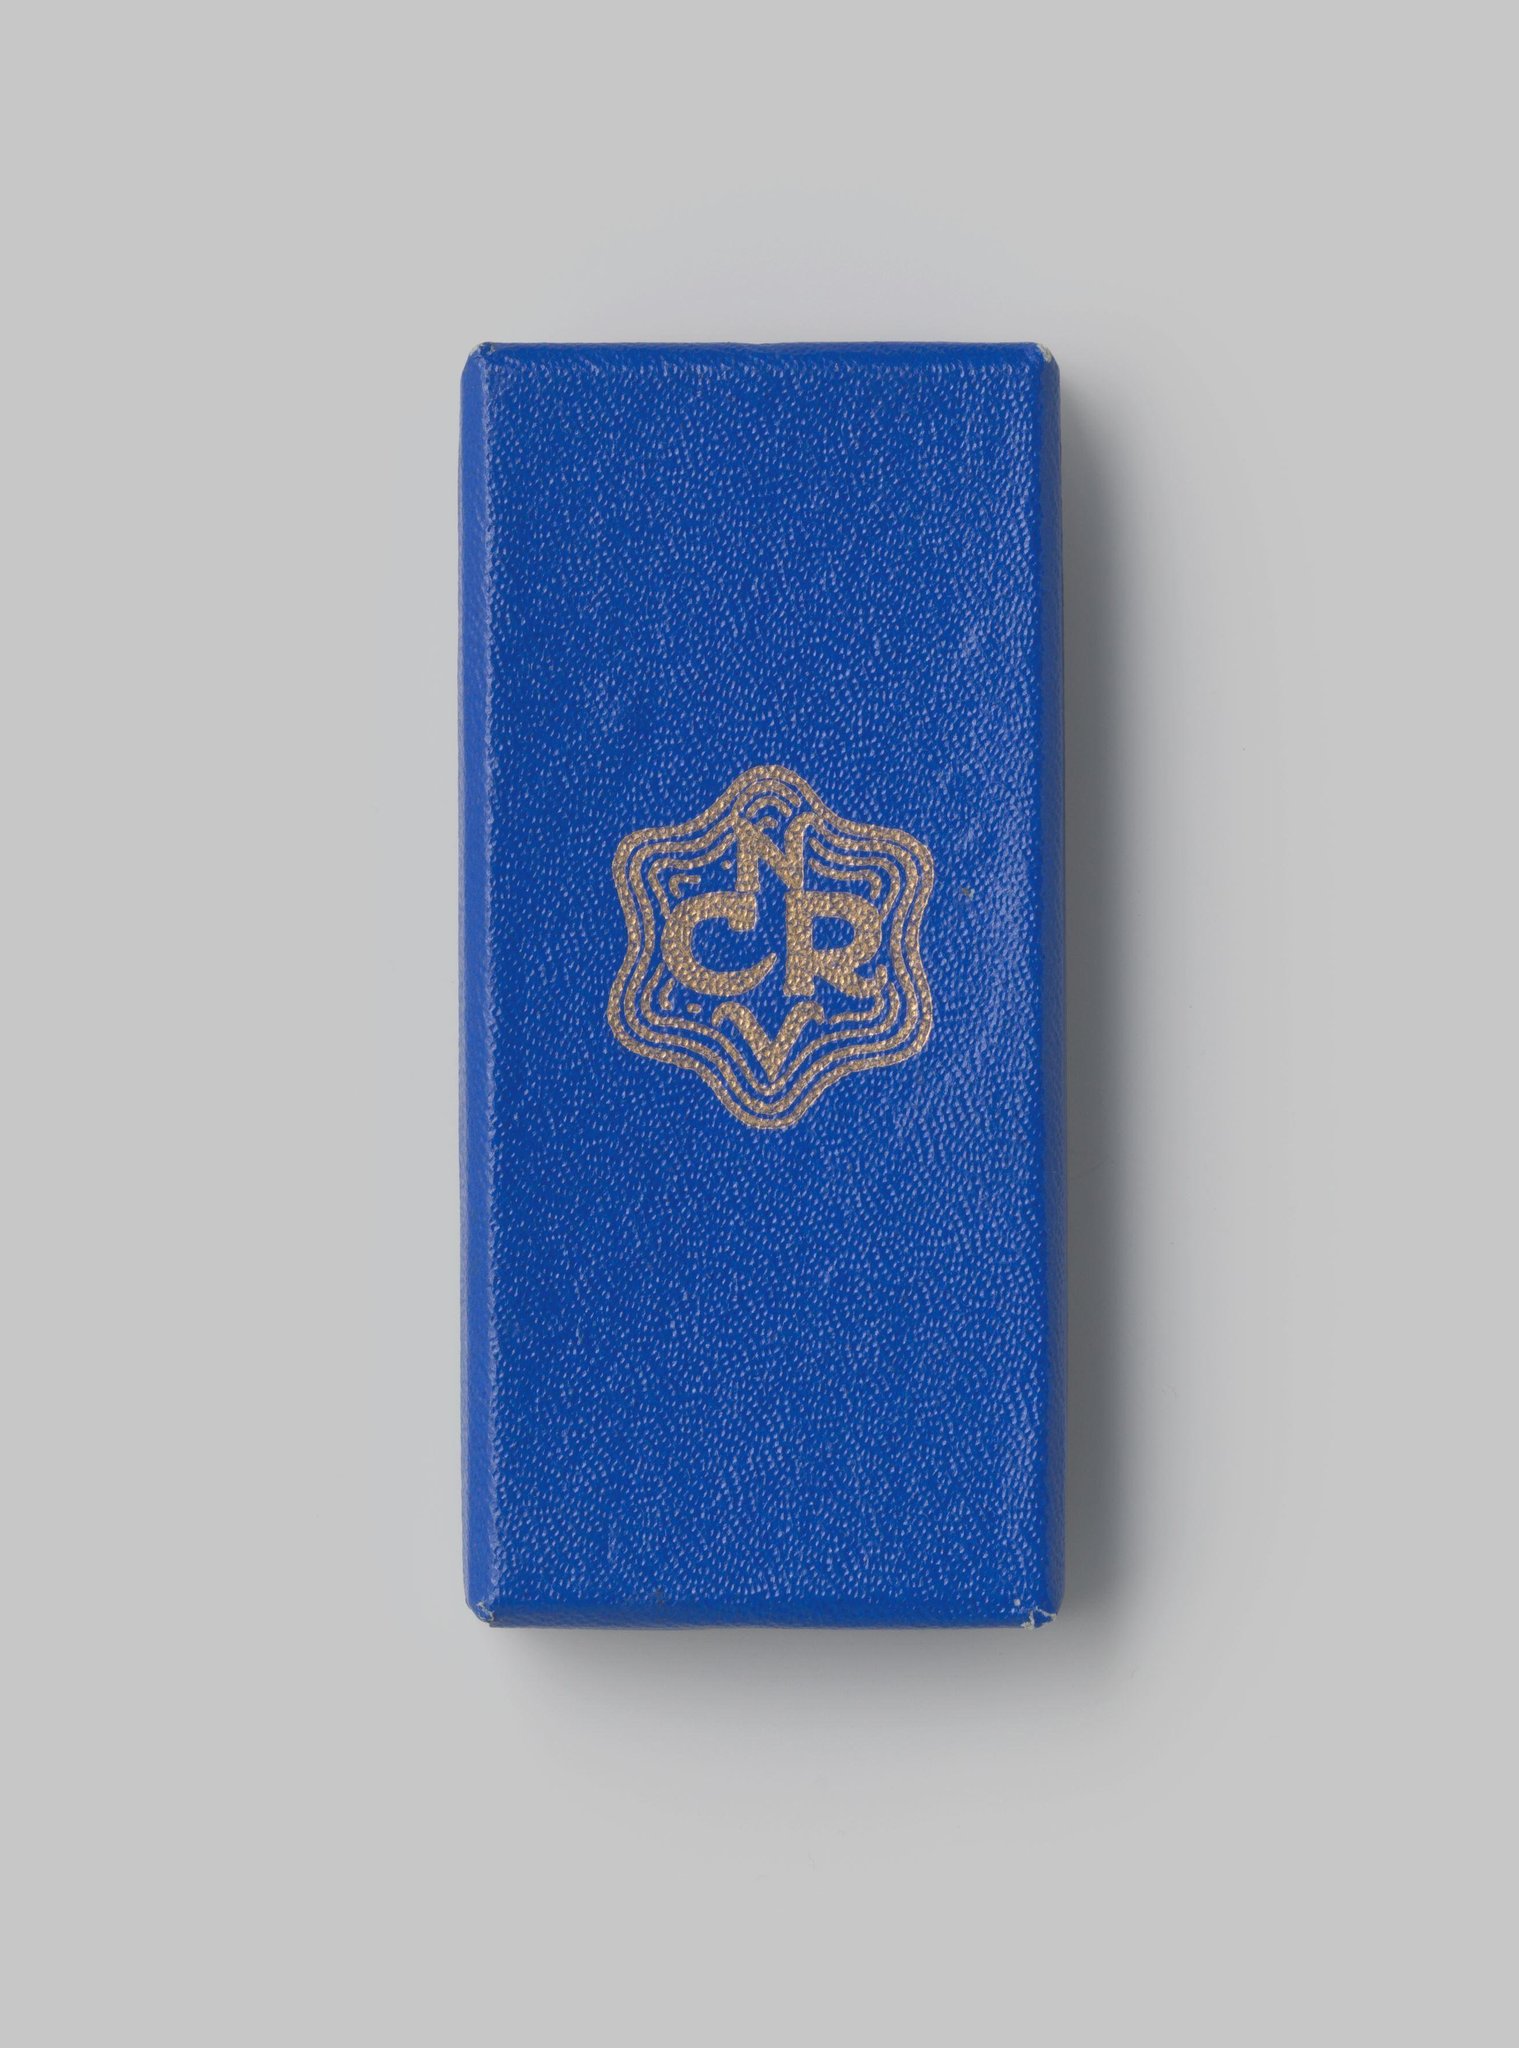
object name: box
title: Orde van verdienste van de Nederlandse Christelijke Radio Vereeniging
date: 1924-1994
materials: cardboard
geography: netherlands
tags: netherlands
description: Rechthoekig kartonnen doosje met blauwe deksel. Aan de binnenkant van de deksel staat 'koninklijke van Kempen & Begeer'.